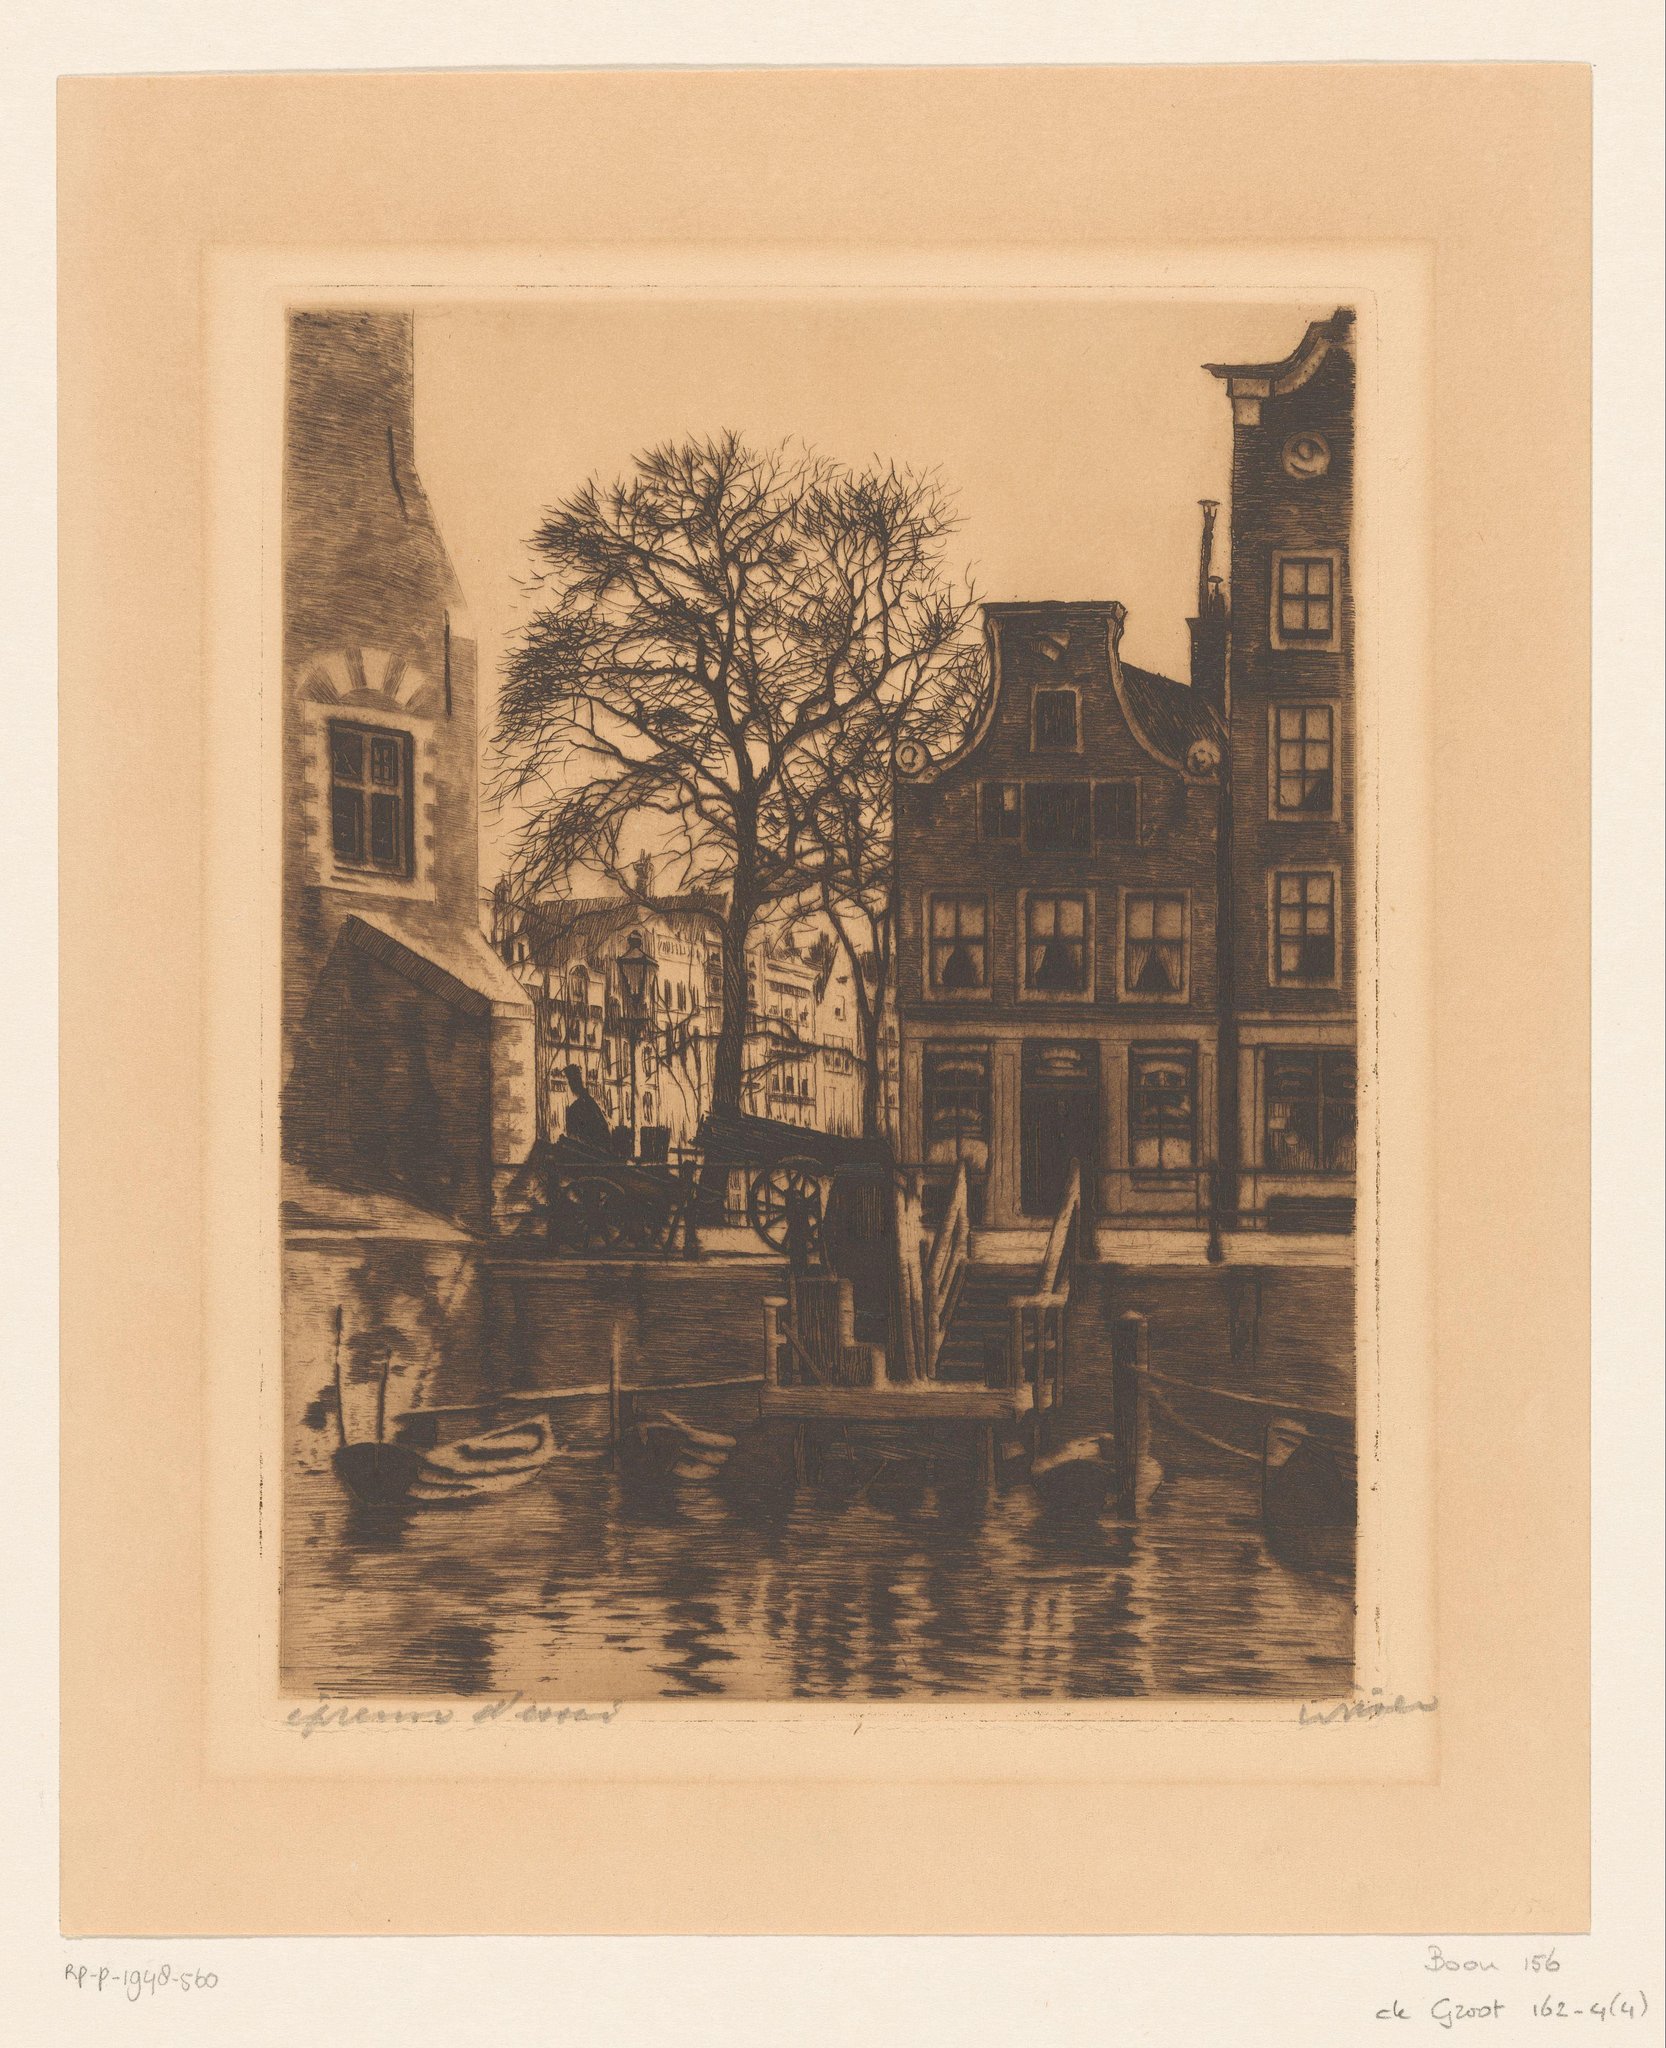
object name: print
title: Overhaal bij de Montelbaanstoren in Amsterdam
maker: willem witsen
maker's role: draughtsman, painter, print maker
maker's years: 1860-1923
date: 1912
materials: paper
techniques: aquatint, etching, intaglio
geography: amsterdam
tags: city-view, and landscape with man-made constructions, canals, waters (in city), the usual house or row of houses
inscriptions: watermark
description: Gezien vanaf de Oude Schans richting de Oude Schans 4.